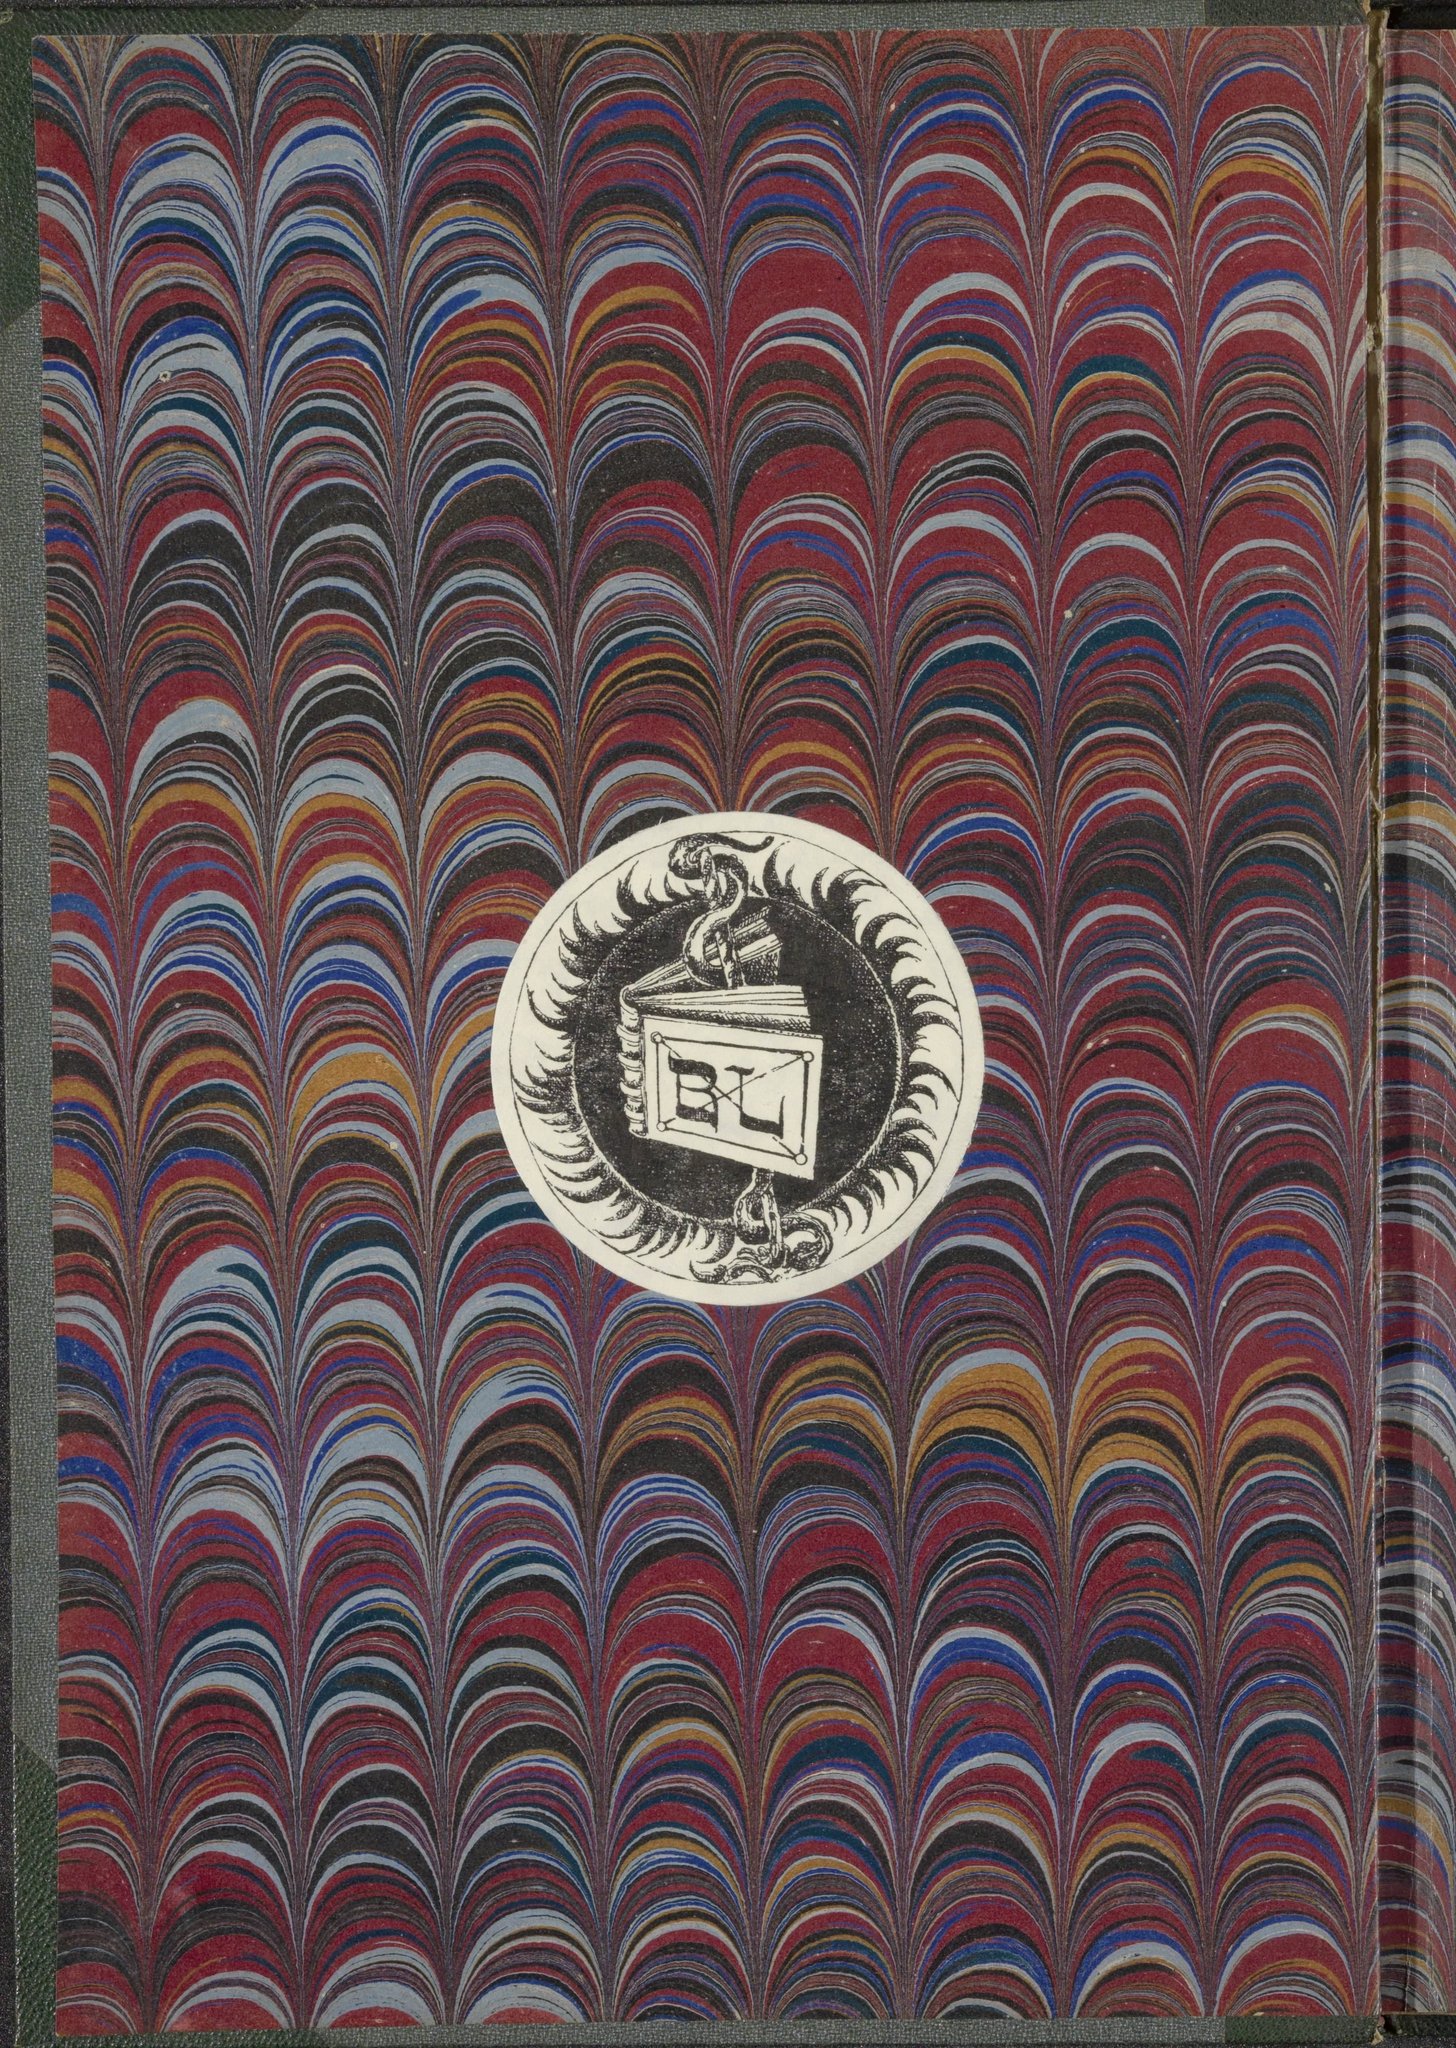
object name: bookplate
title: Rond ex libris met een aesculaap tussen de bladzijden van een boek en de letters BL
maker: Anonymous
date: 1800-1950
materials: paper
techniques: woodcut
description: Rond ex libris met een aesculaap tussen de bladzijden van een boek. Op het boek de letters: BL. Op de achtergrond een zwarte cirkel met een rand van zwarte vlammen. Ex libris geplakt op dekblad. Deze prent maakt deel uit van een album.